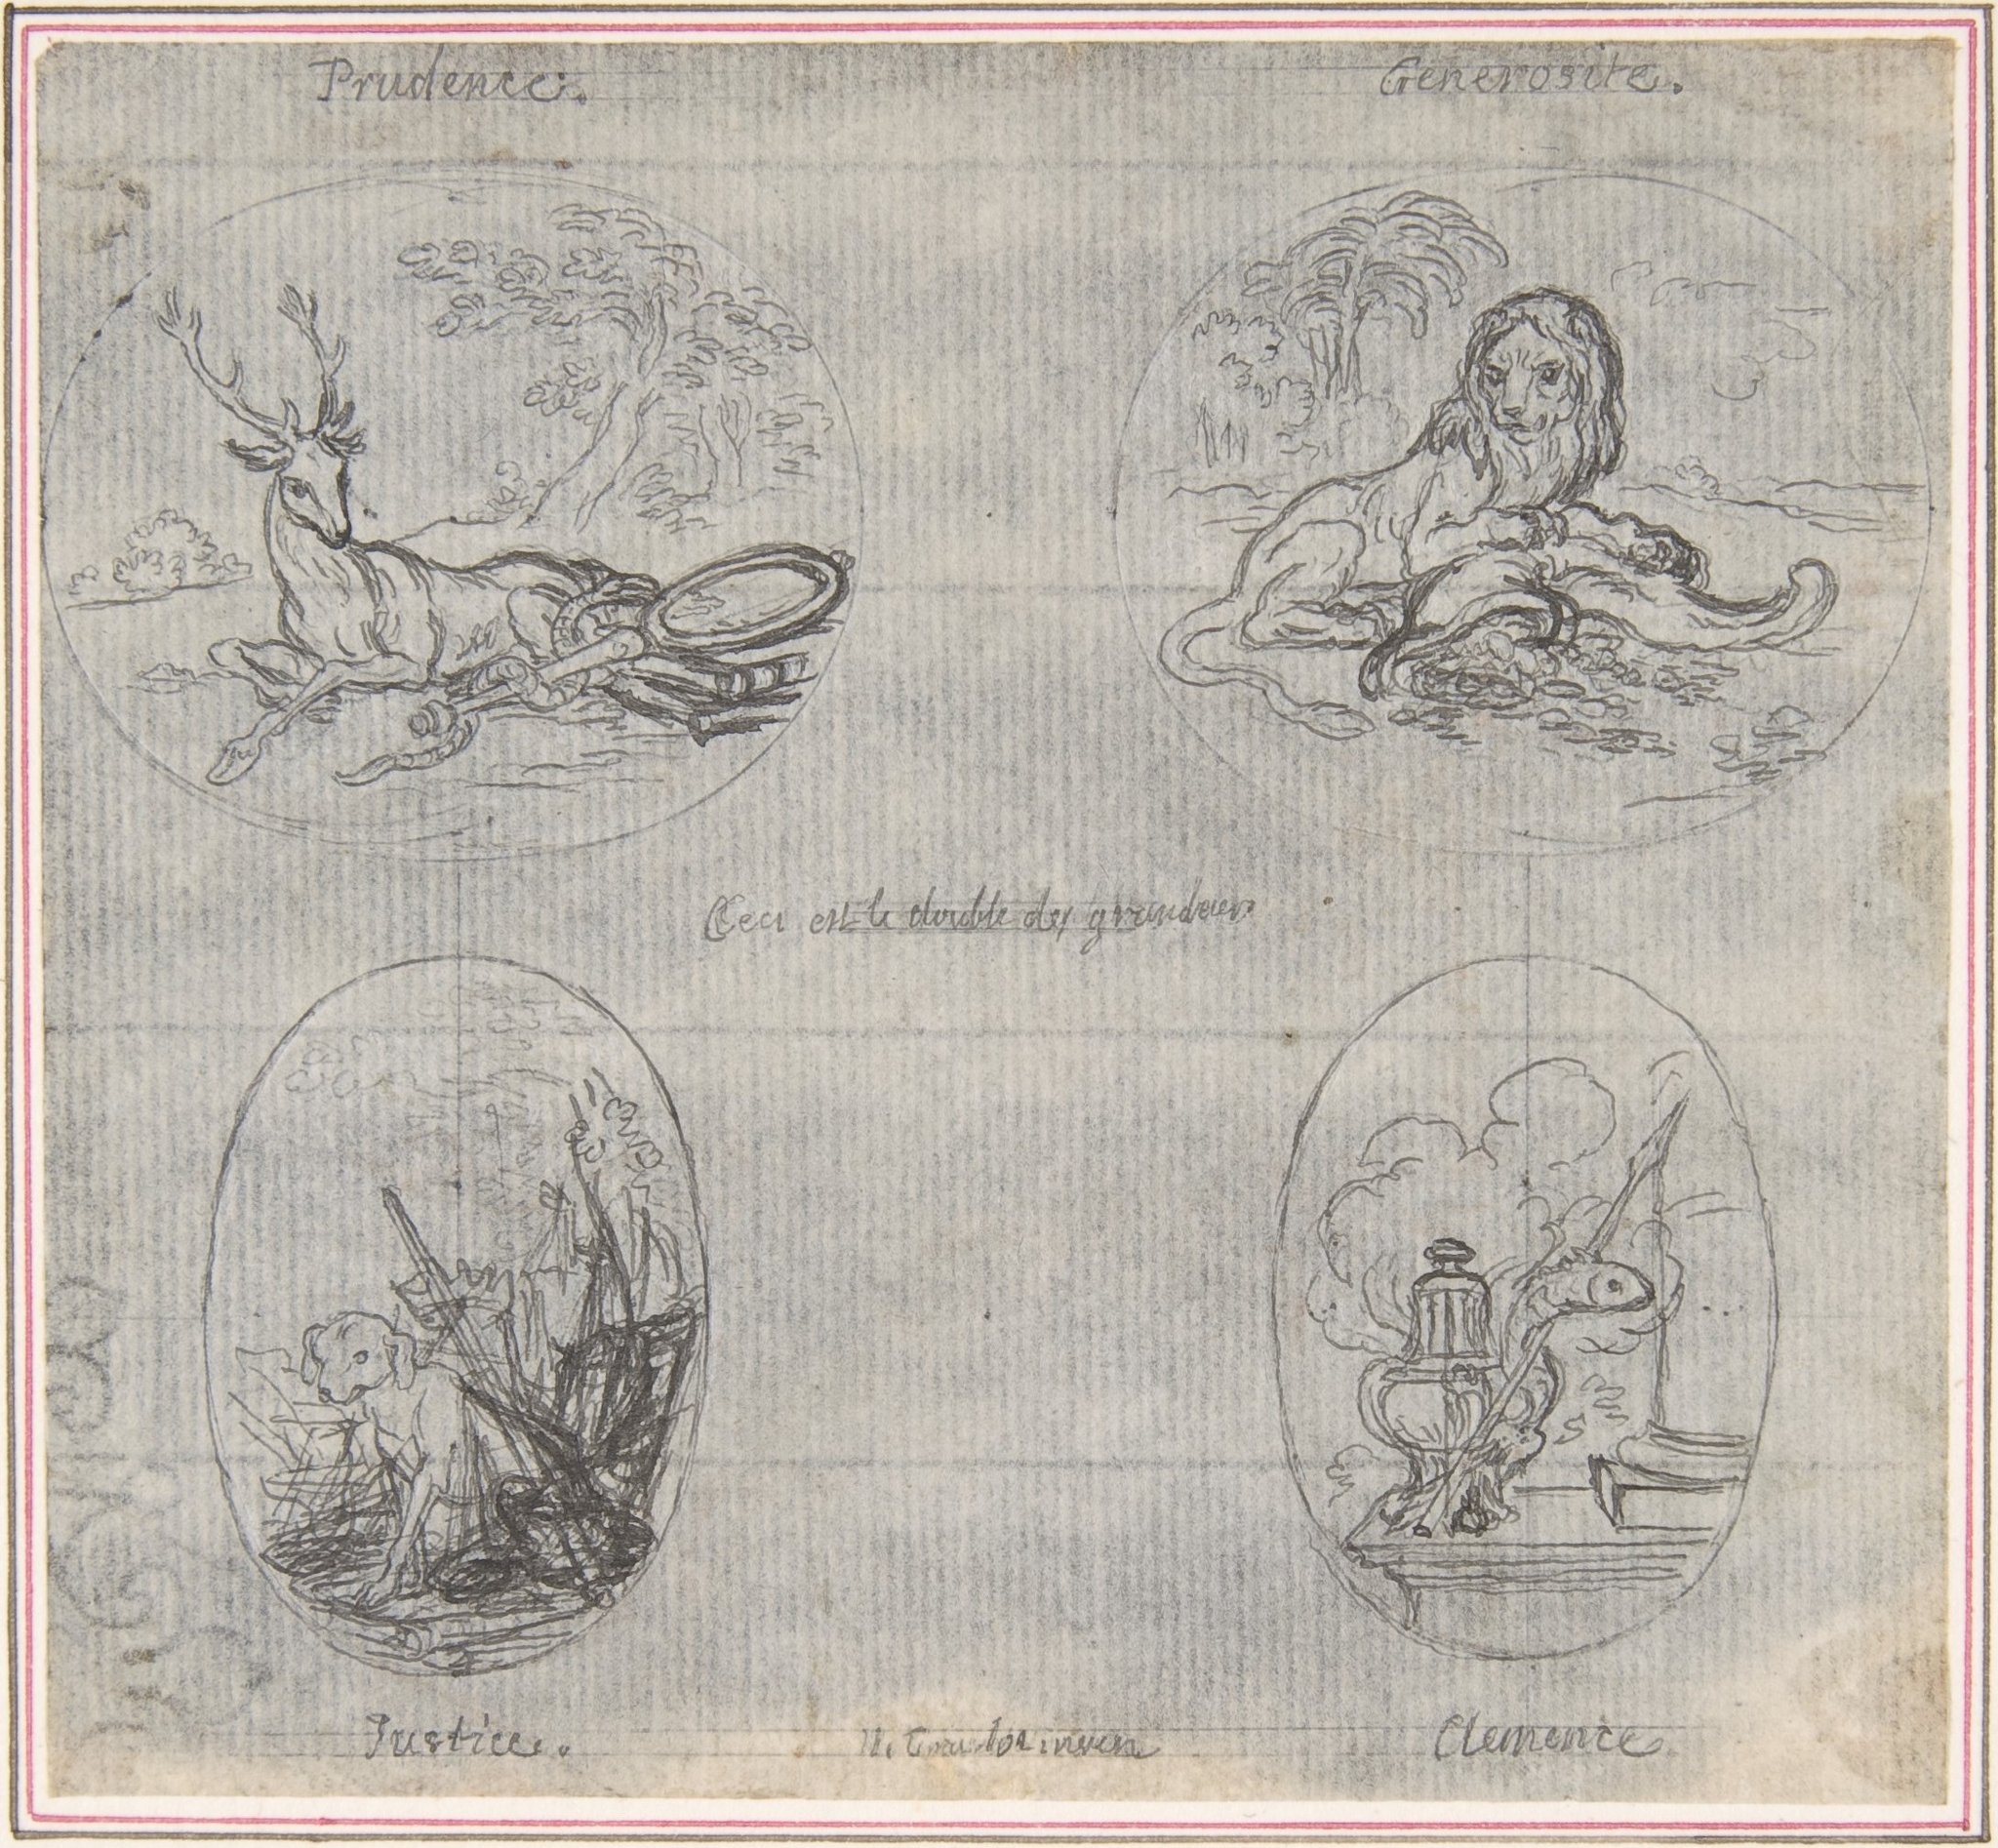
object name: drawing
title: Four Small Allegories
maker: hubert françois gravelot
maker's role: artist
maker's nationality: french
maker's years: 1699-1773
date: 1701-1800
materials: graphite, ink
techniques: pen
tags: deer,dogs,fish,lions,trees